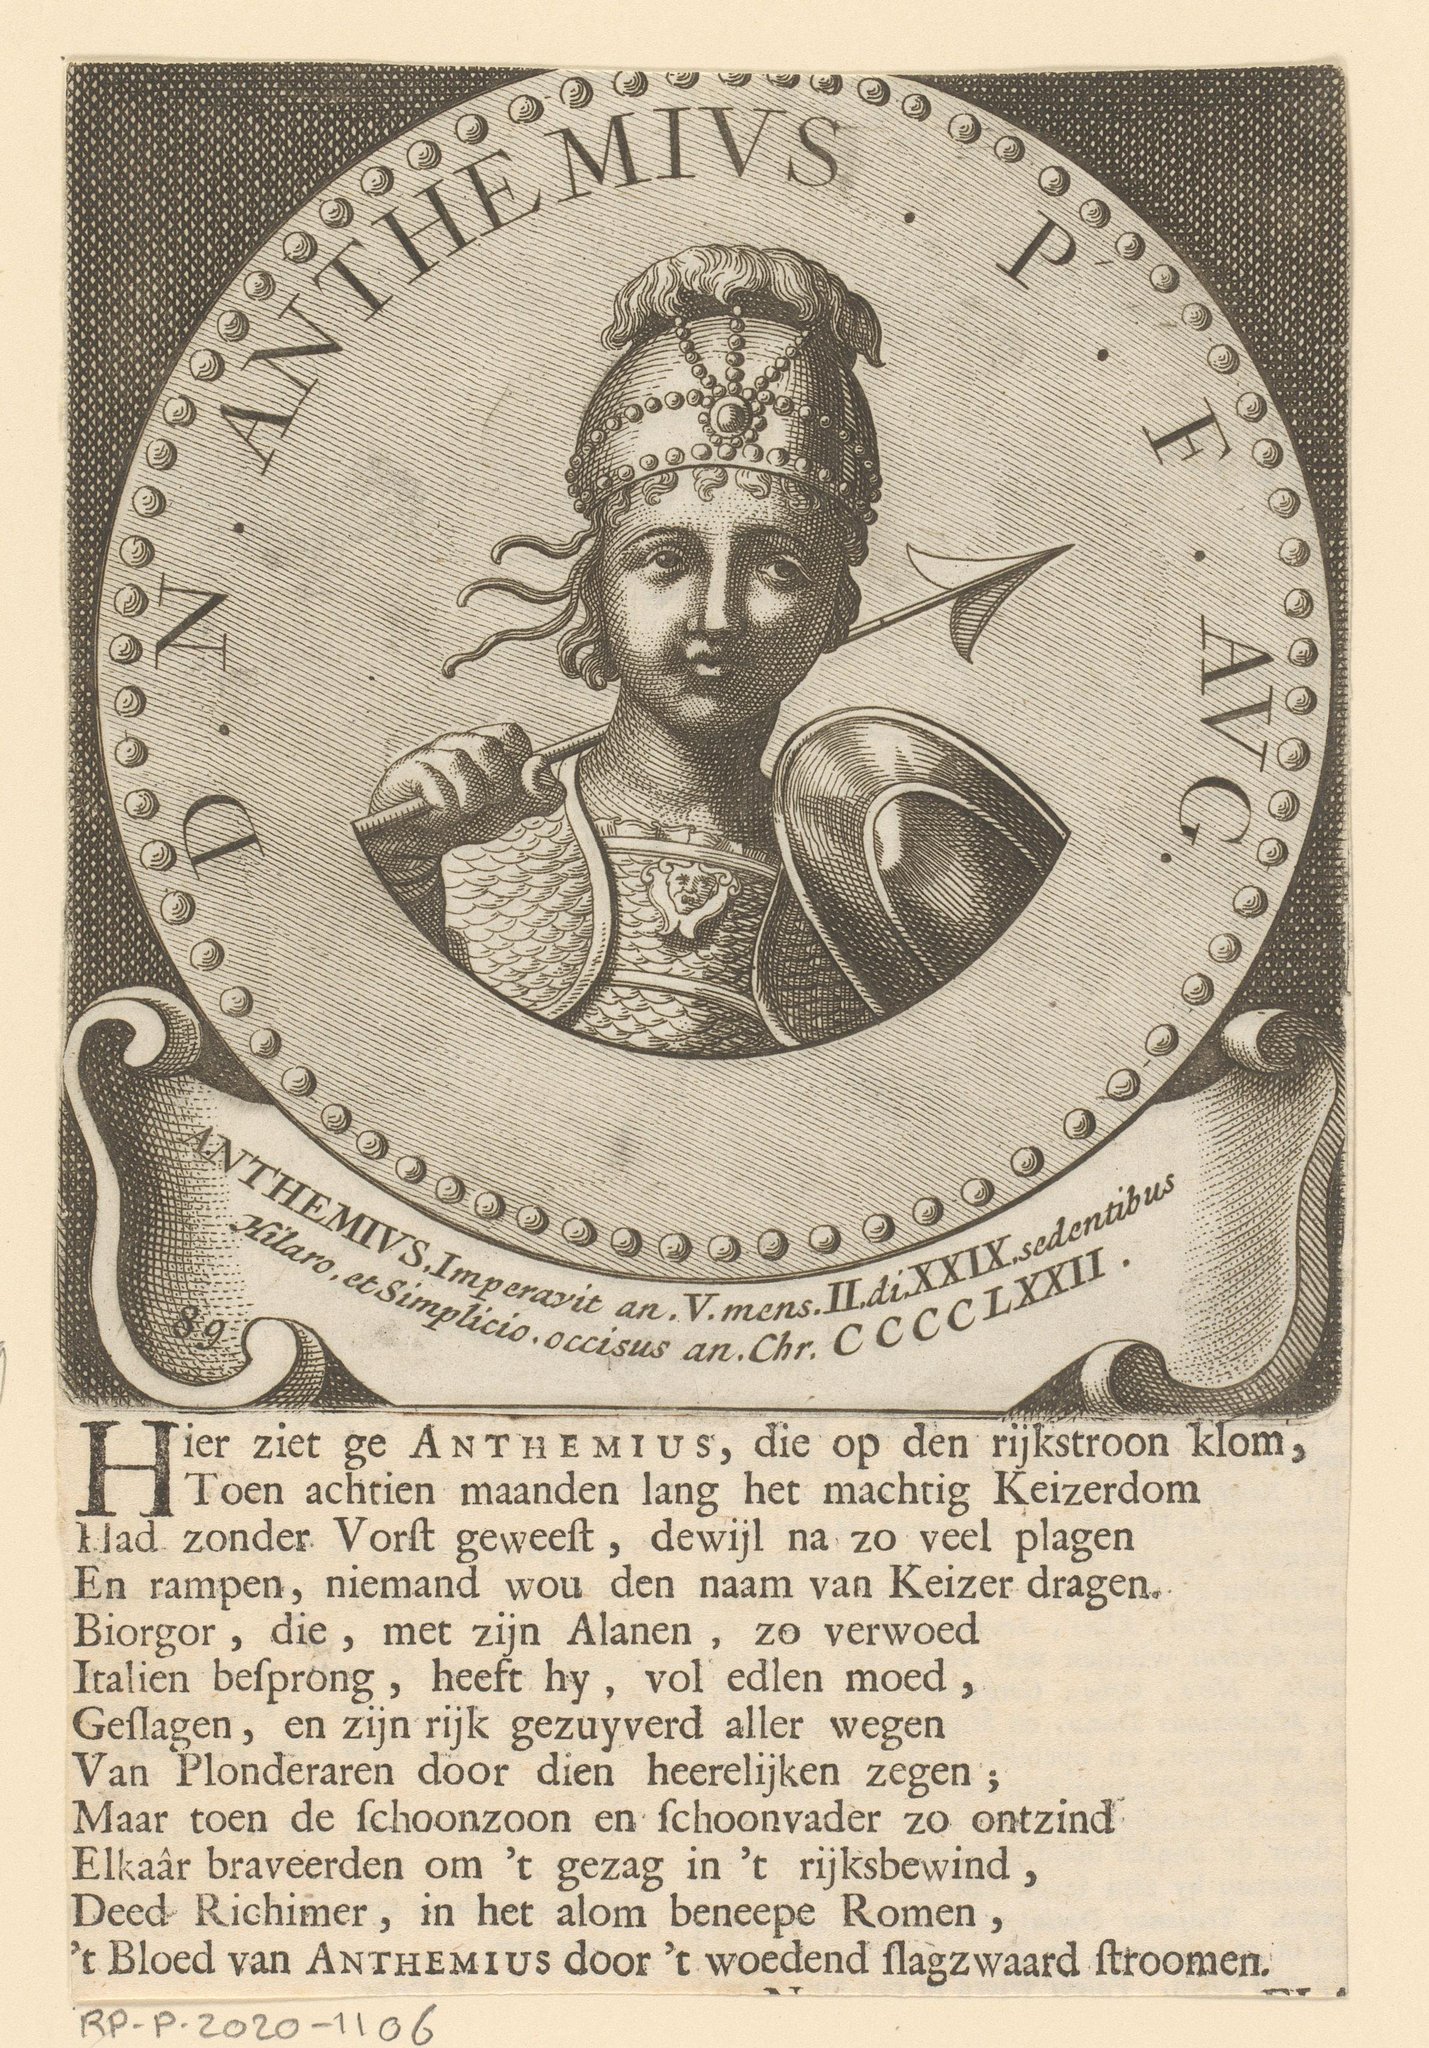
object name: book illustration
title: Anthemius (...)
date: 1697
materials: paper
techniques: engraving, etching, letterpress printing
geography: utrecht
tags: historical persons, emperor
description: Prent uit: Bogaert, Abraham. De Roomsche monarchy, vertoont in de muntbeelden der westersche en oostersche keizeren (...). Utrecht: François Halma en Willem van de Water, 1697, p. 285. Eerste staat verschenen in een grotere prent met twaalf portretten, gedateerd 1695.